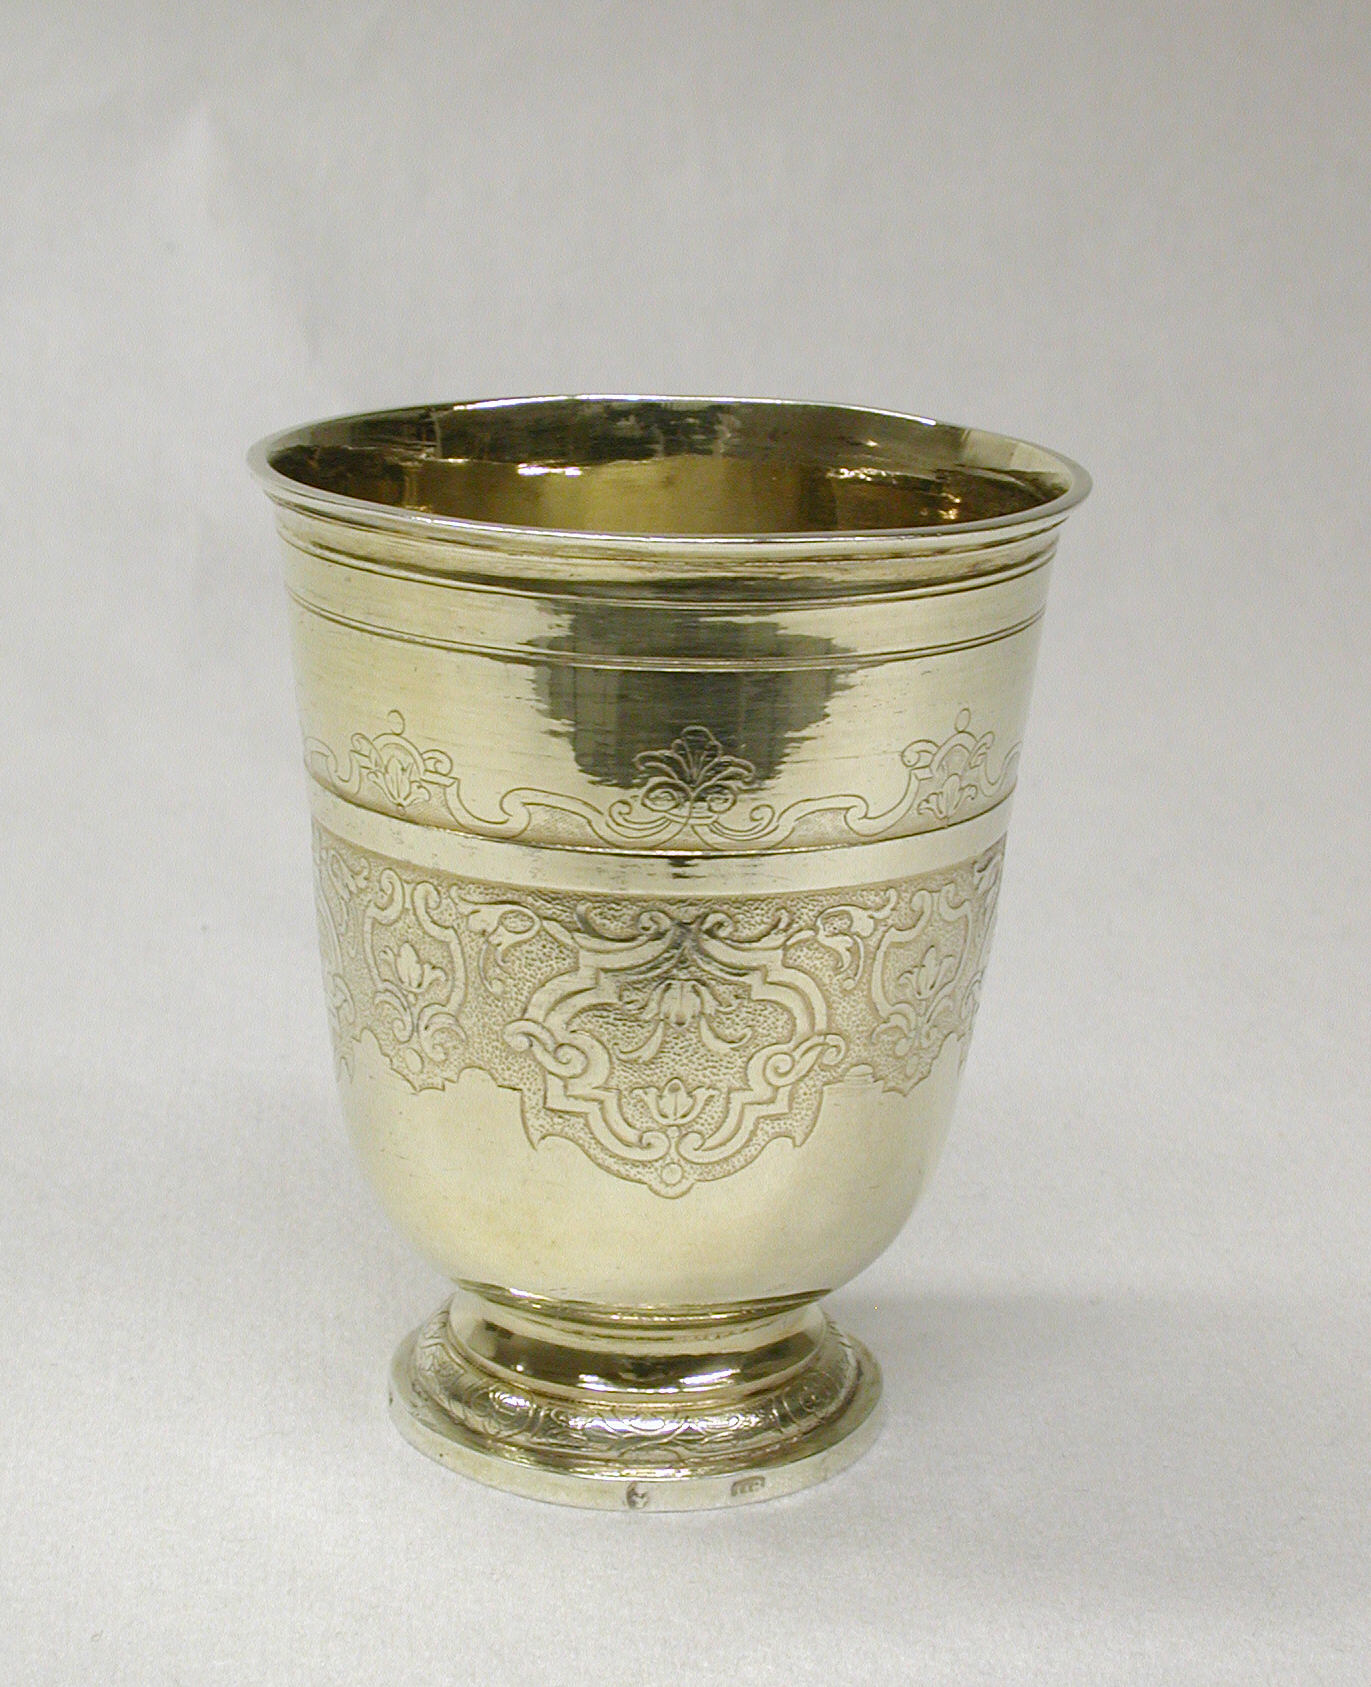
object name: beaker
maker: johann jakob bruglocher ii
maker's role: maker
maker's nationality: german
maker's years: 1710-1752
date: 1743-1745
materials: silver gilt